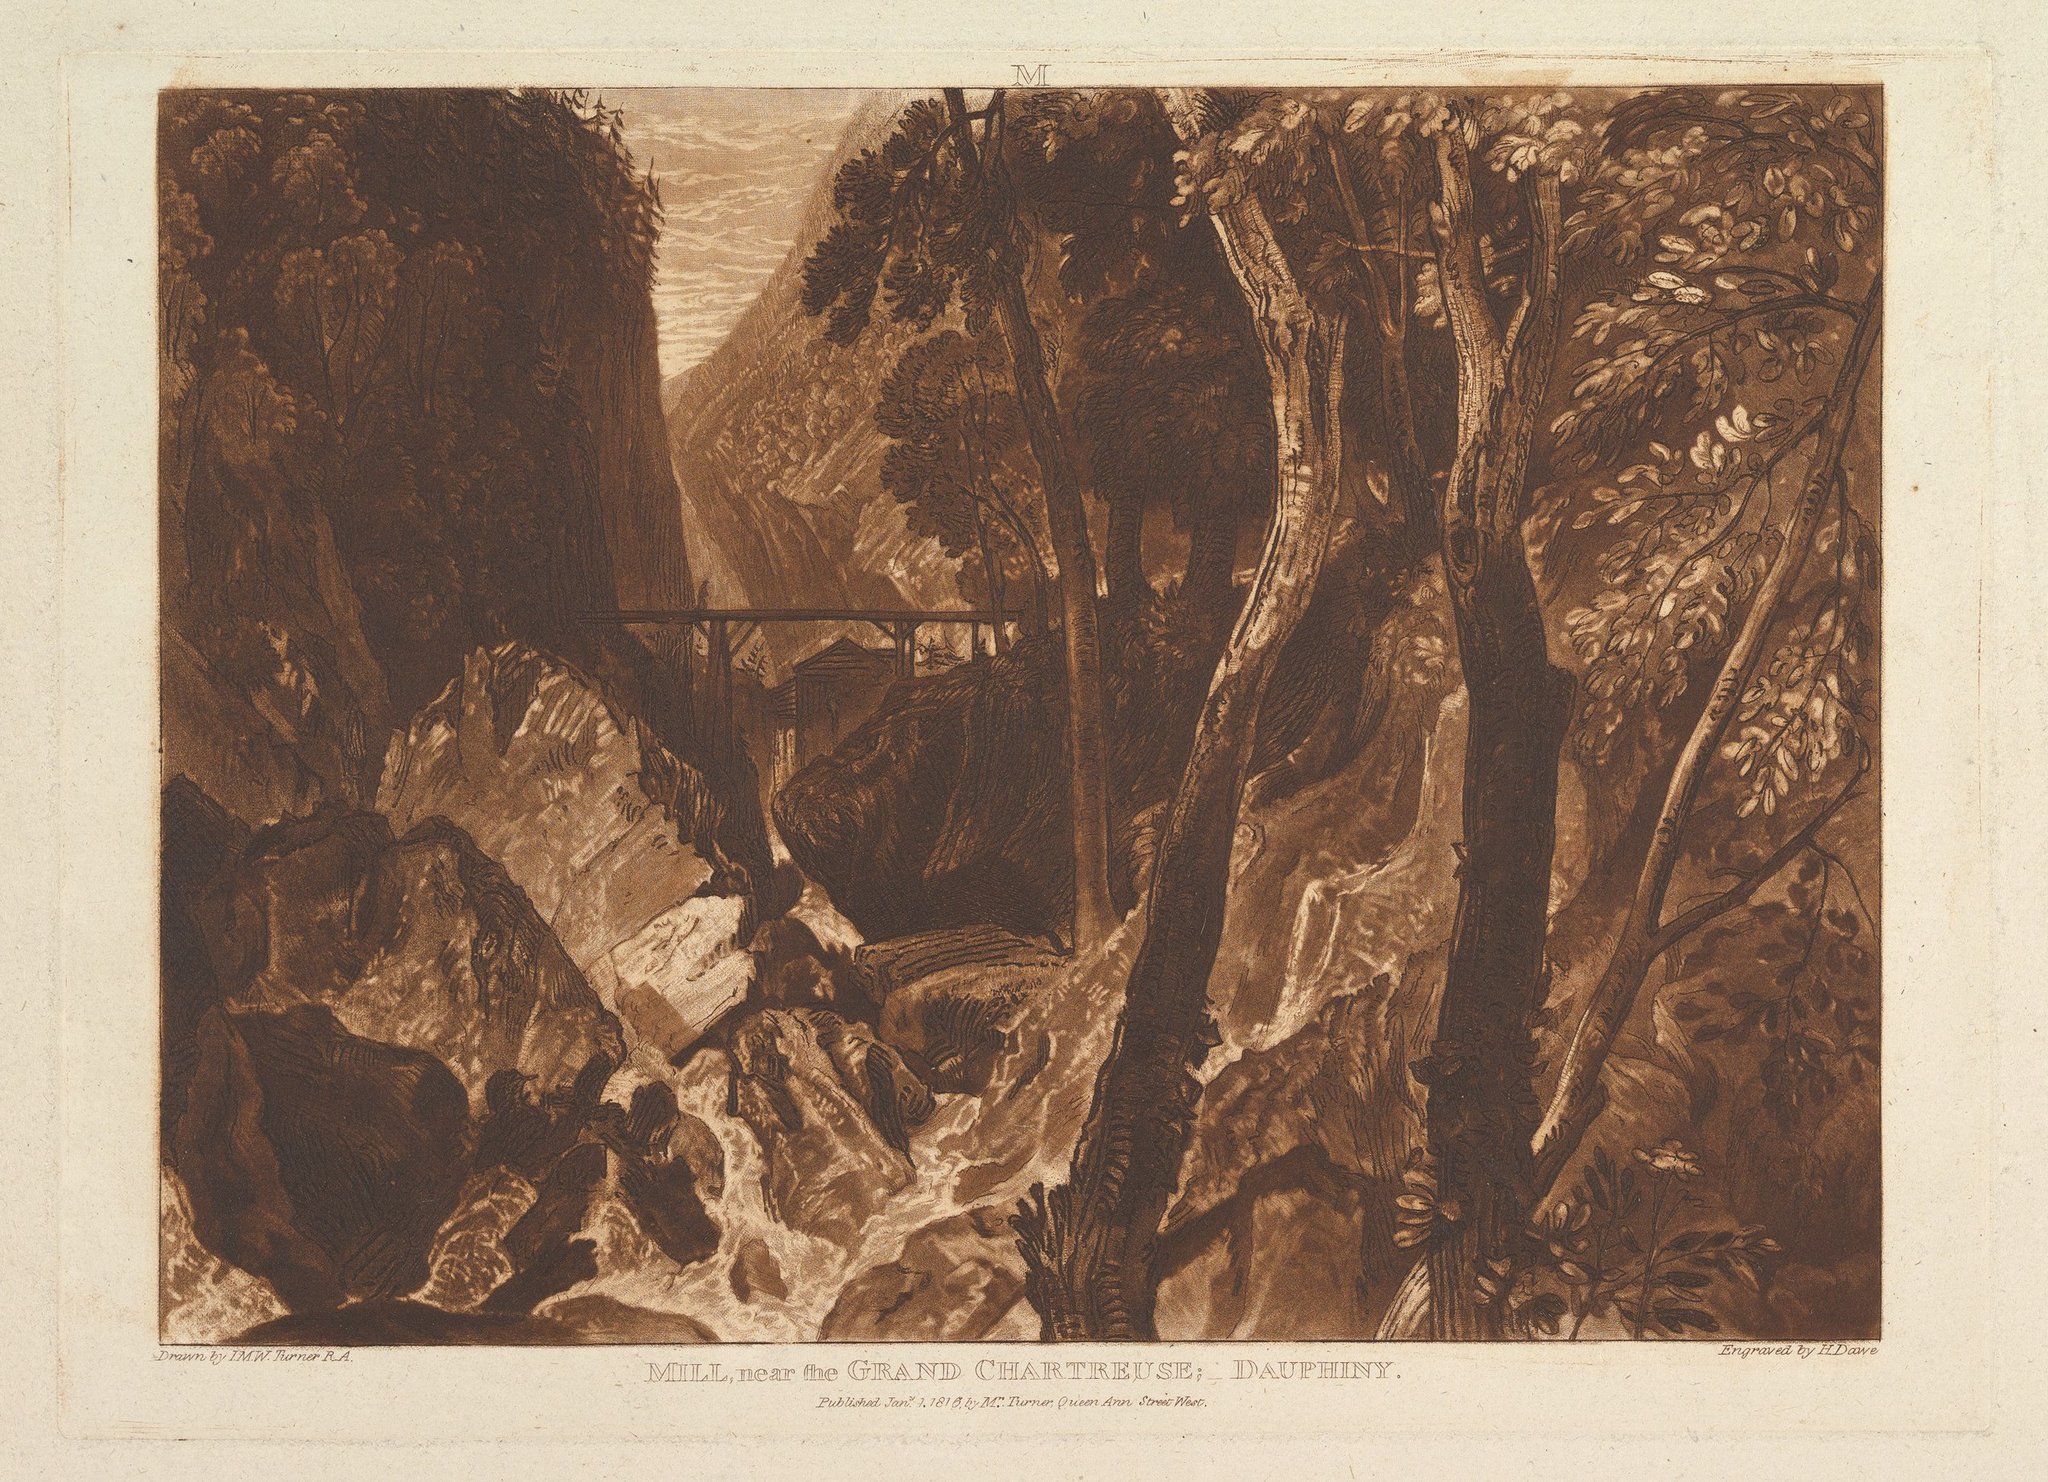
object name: print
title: Mill Near the Grand Chartreuse, Dauphiny, part XI, plate 54 from "Liber Studiorum"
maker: joseph mallord william turner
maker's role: artist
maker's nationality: british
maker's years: 1775-1851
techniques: etching, mezzotint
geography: london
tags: trees